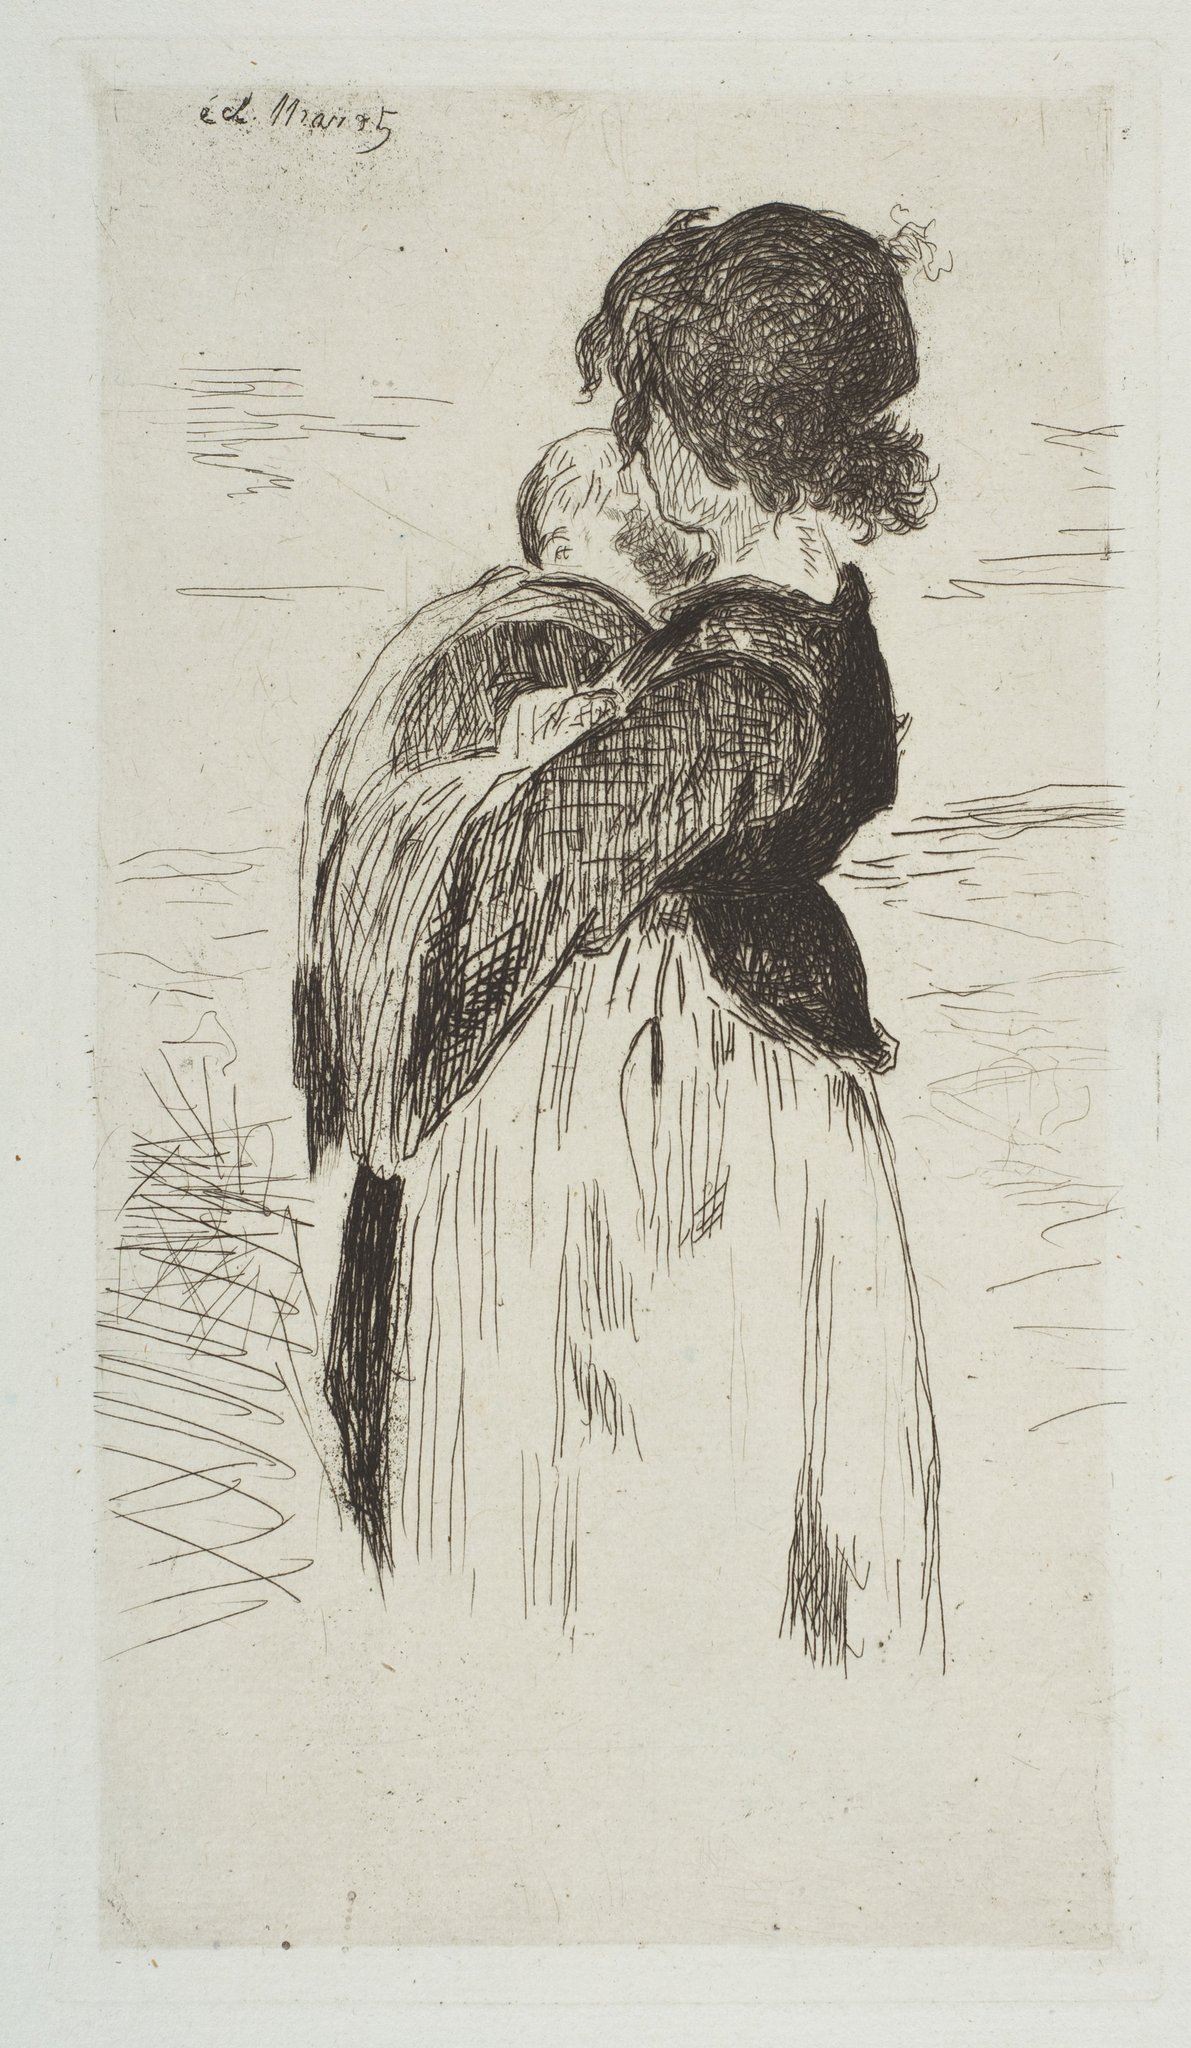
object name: print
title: The Little Girl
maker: édouard manet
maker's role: artist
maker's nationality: french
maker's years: 1832-1883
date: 1861-1862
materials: paper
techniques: drypoint, etching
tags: infants,women